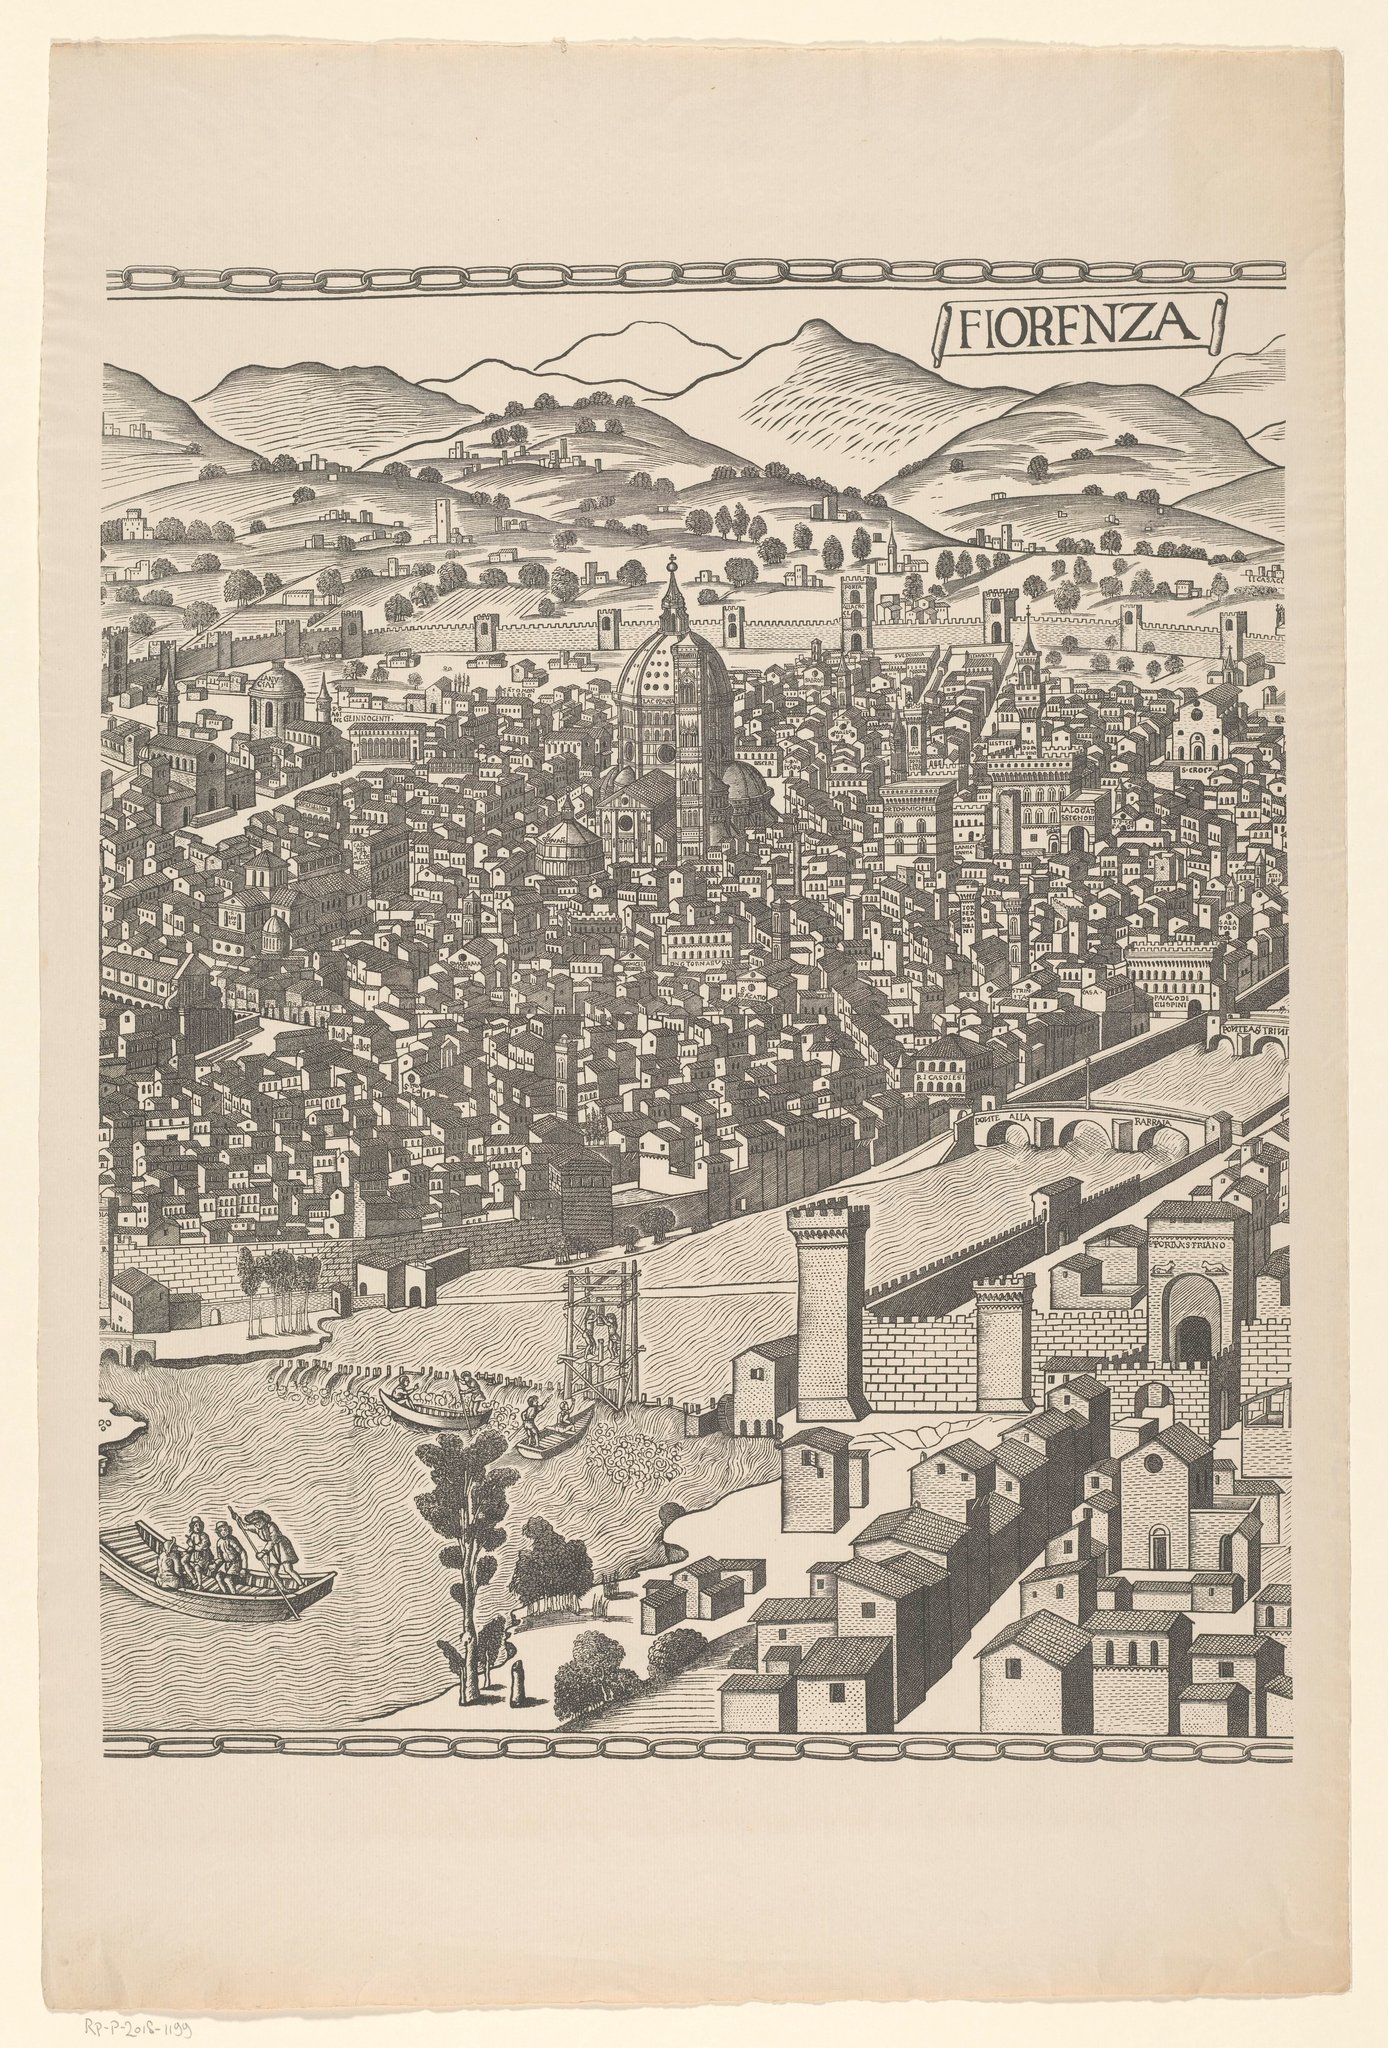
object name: facsimile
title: Fiorenza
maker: lucantonio degli uberti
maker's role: print maker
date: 1879-1949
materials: paper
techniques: photograph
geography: florence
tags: prospect of city, town panorama, silhouette of city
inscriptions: collector's mark: Lugt 2228, check stamp: ‘Reichsdruck’, collector's mark: Lugt 4925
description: Middelste deel van een gezicht op Florence bestaande uit drie delen, ook wel de Pianta della Catena genoemd.